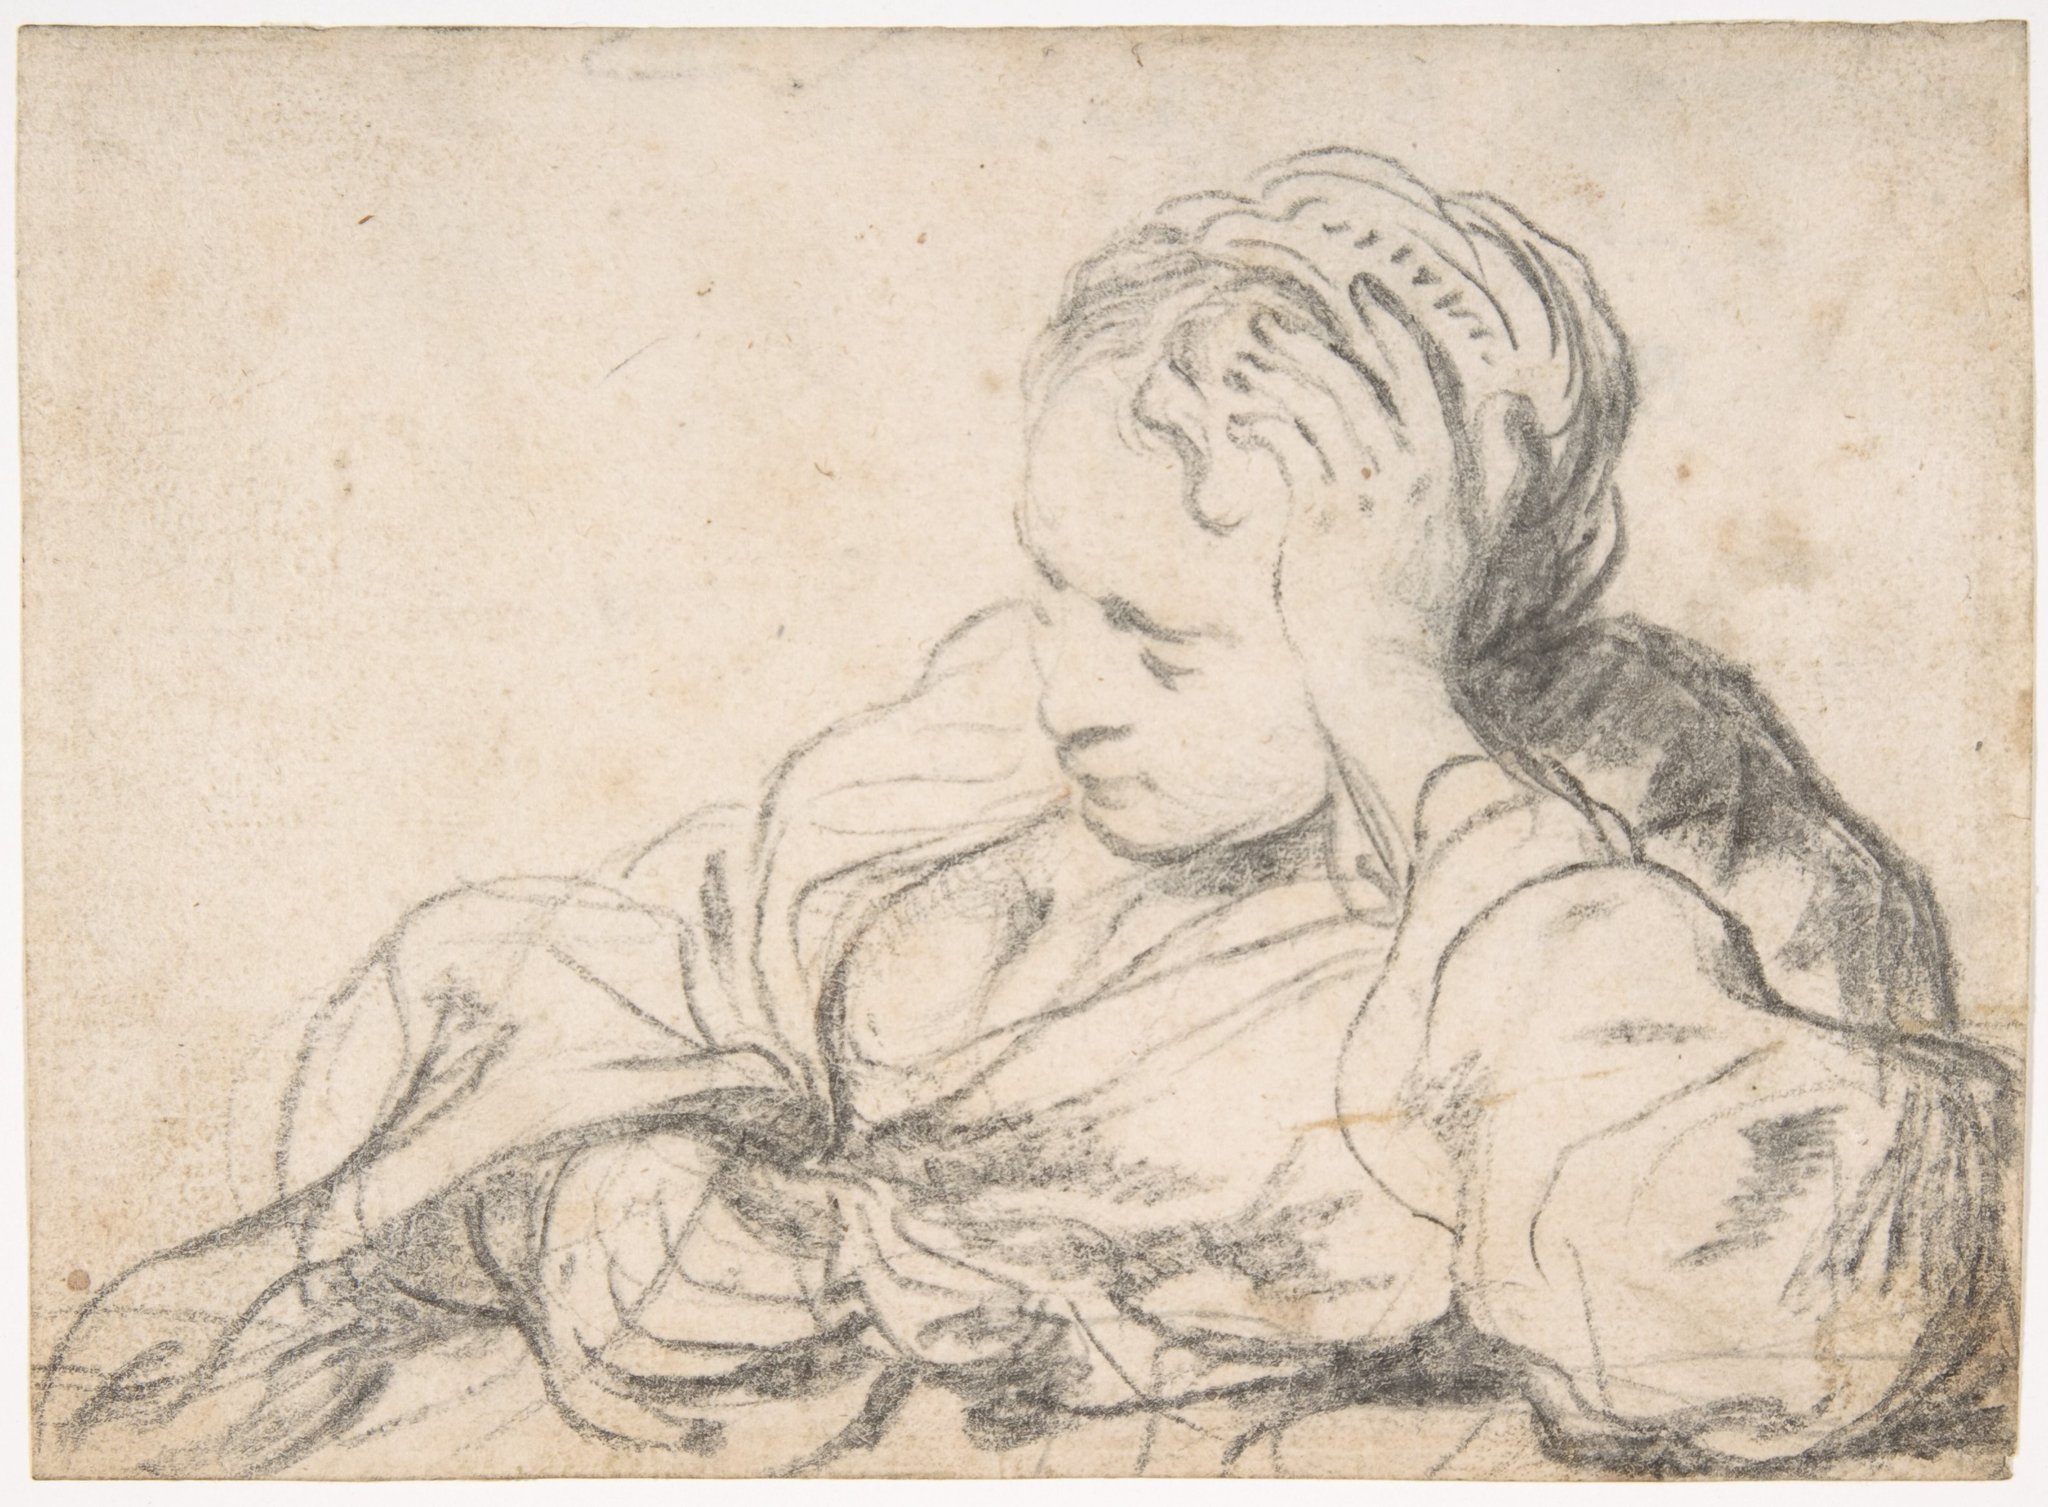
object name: drawing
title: A Woman Asleep (recto); Landscape Composition with Well-Sweep (verso)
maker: govert flinck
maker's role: artist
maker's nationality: dutch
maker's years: 1615-1660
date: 1633-1636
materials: chalk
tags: sleeping,women